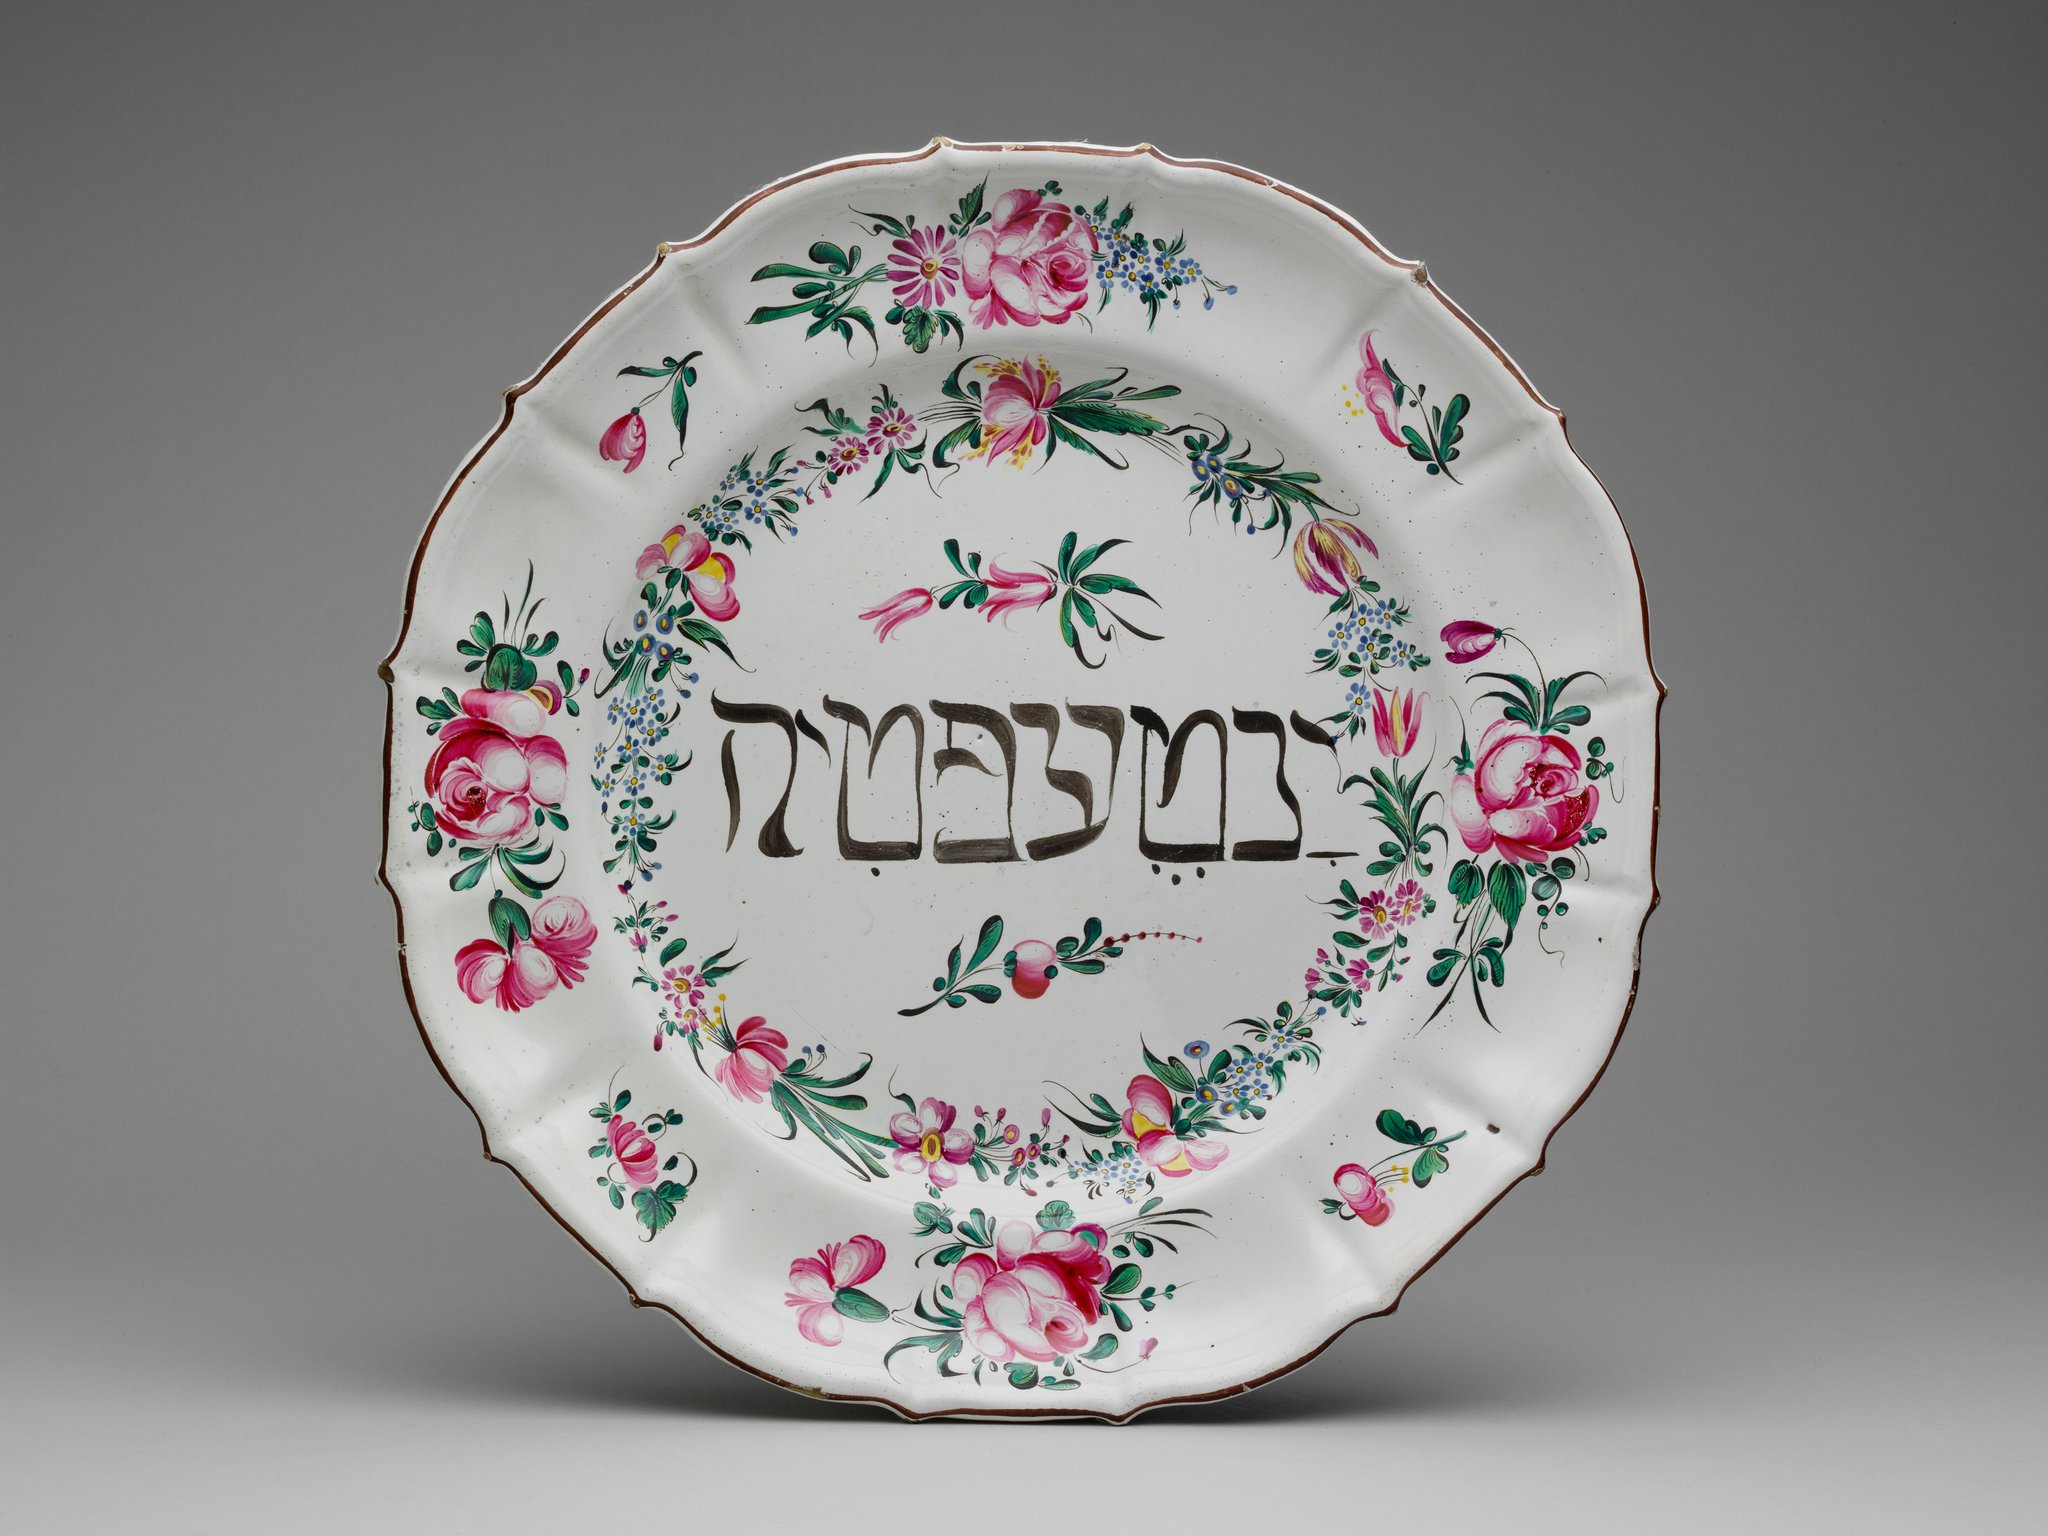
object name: dish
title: Holiday dish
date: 1890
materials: earthenware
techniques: glazing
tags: flowers